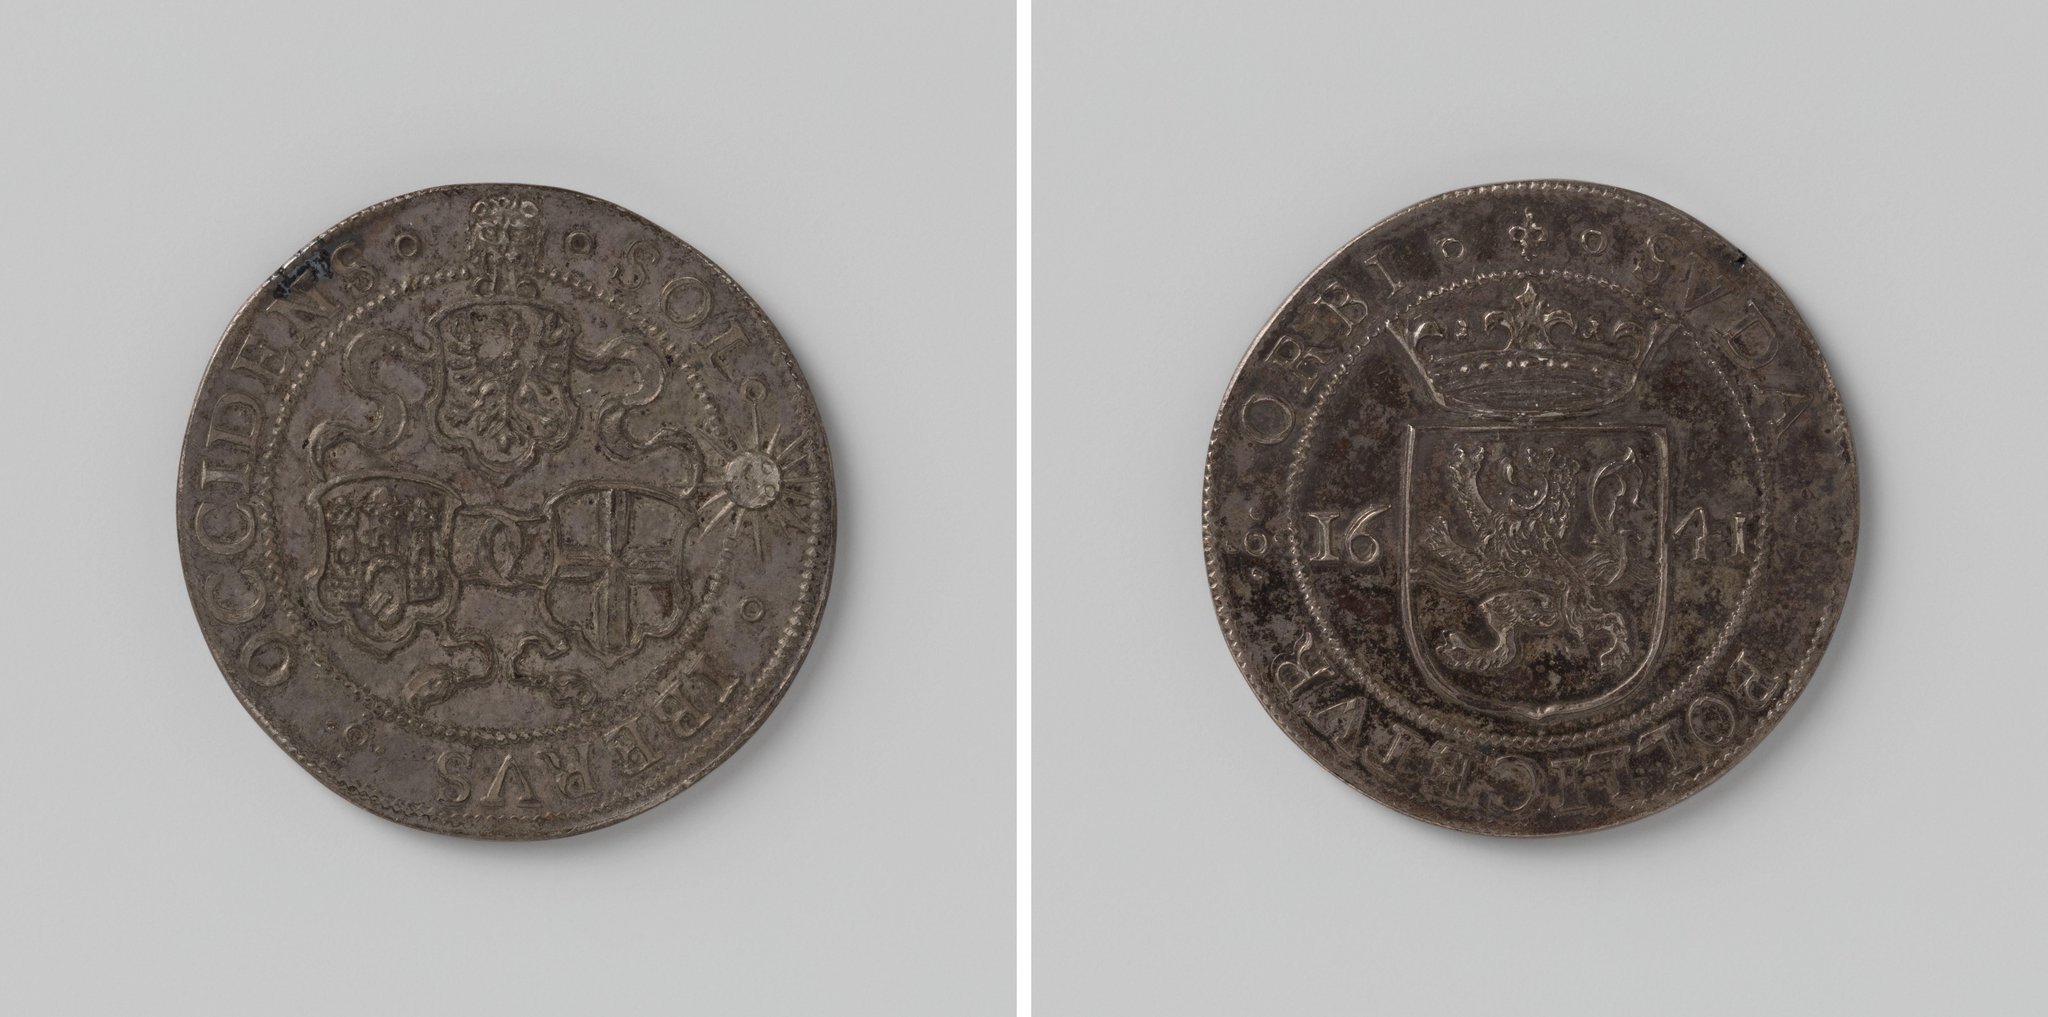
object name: history medal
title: Naderende ondergang van de Spaanse macht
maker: Anonymous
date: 1641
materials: silver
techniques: striking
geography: overijssel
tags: deventer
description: Zilveren penning. Voorzijde: drie met lint verbonden wapenschilden (Kampen, Deventer, Zwolle) beschenen door een zon binnen omschrift. Keerzijde: wapenschild van Overijssel tussen jaartal binnen omschrift.